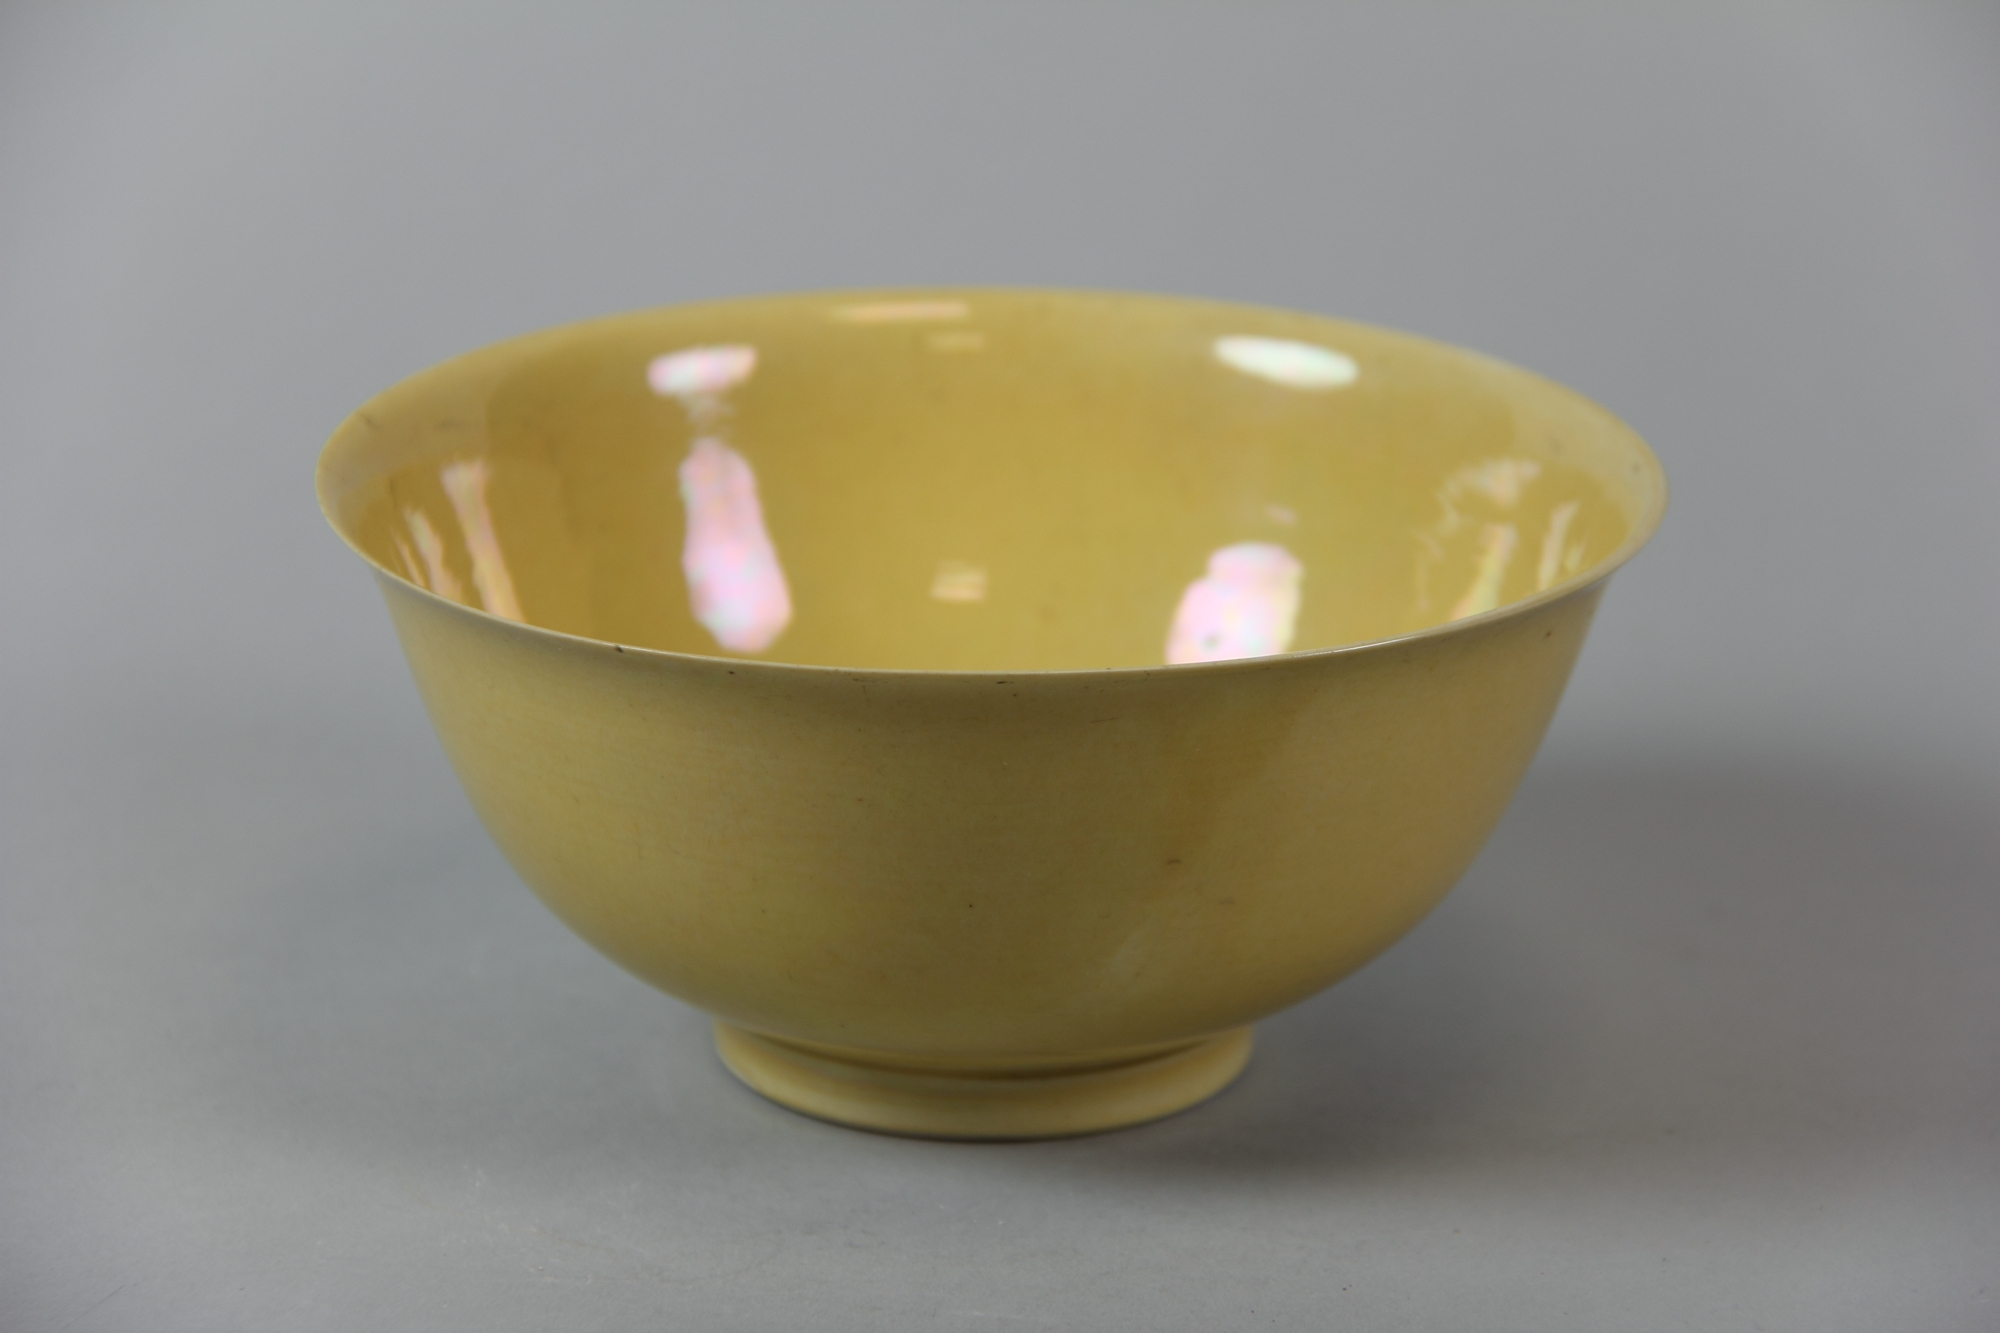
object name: bowl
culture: chinese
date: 1662-1722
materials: glaze, porcelain